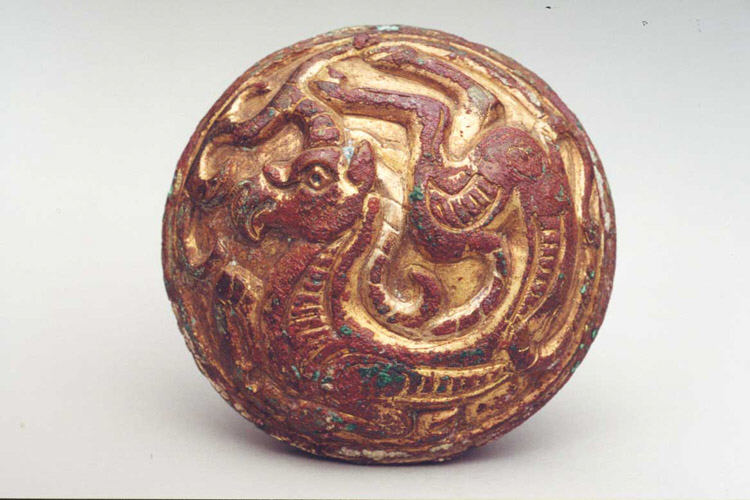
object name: zither string anchor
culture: north chinese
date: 300-101 BCE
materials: bronze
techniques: gilding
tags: dragons